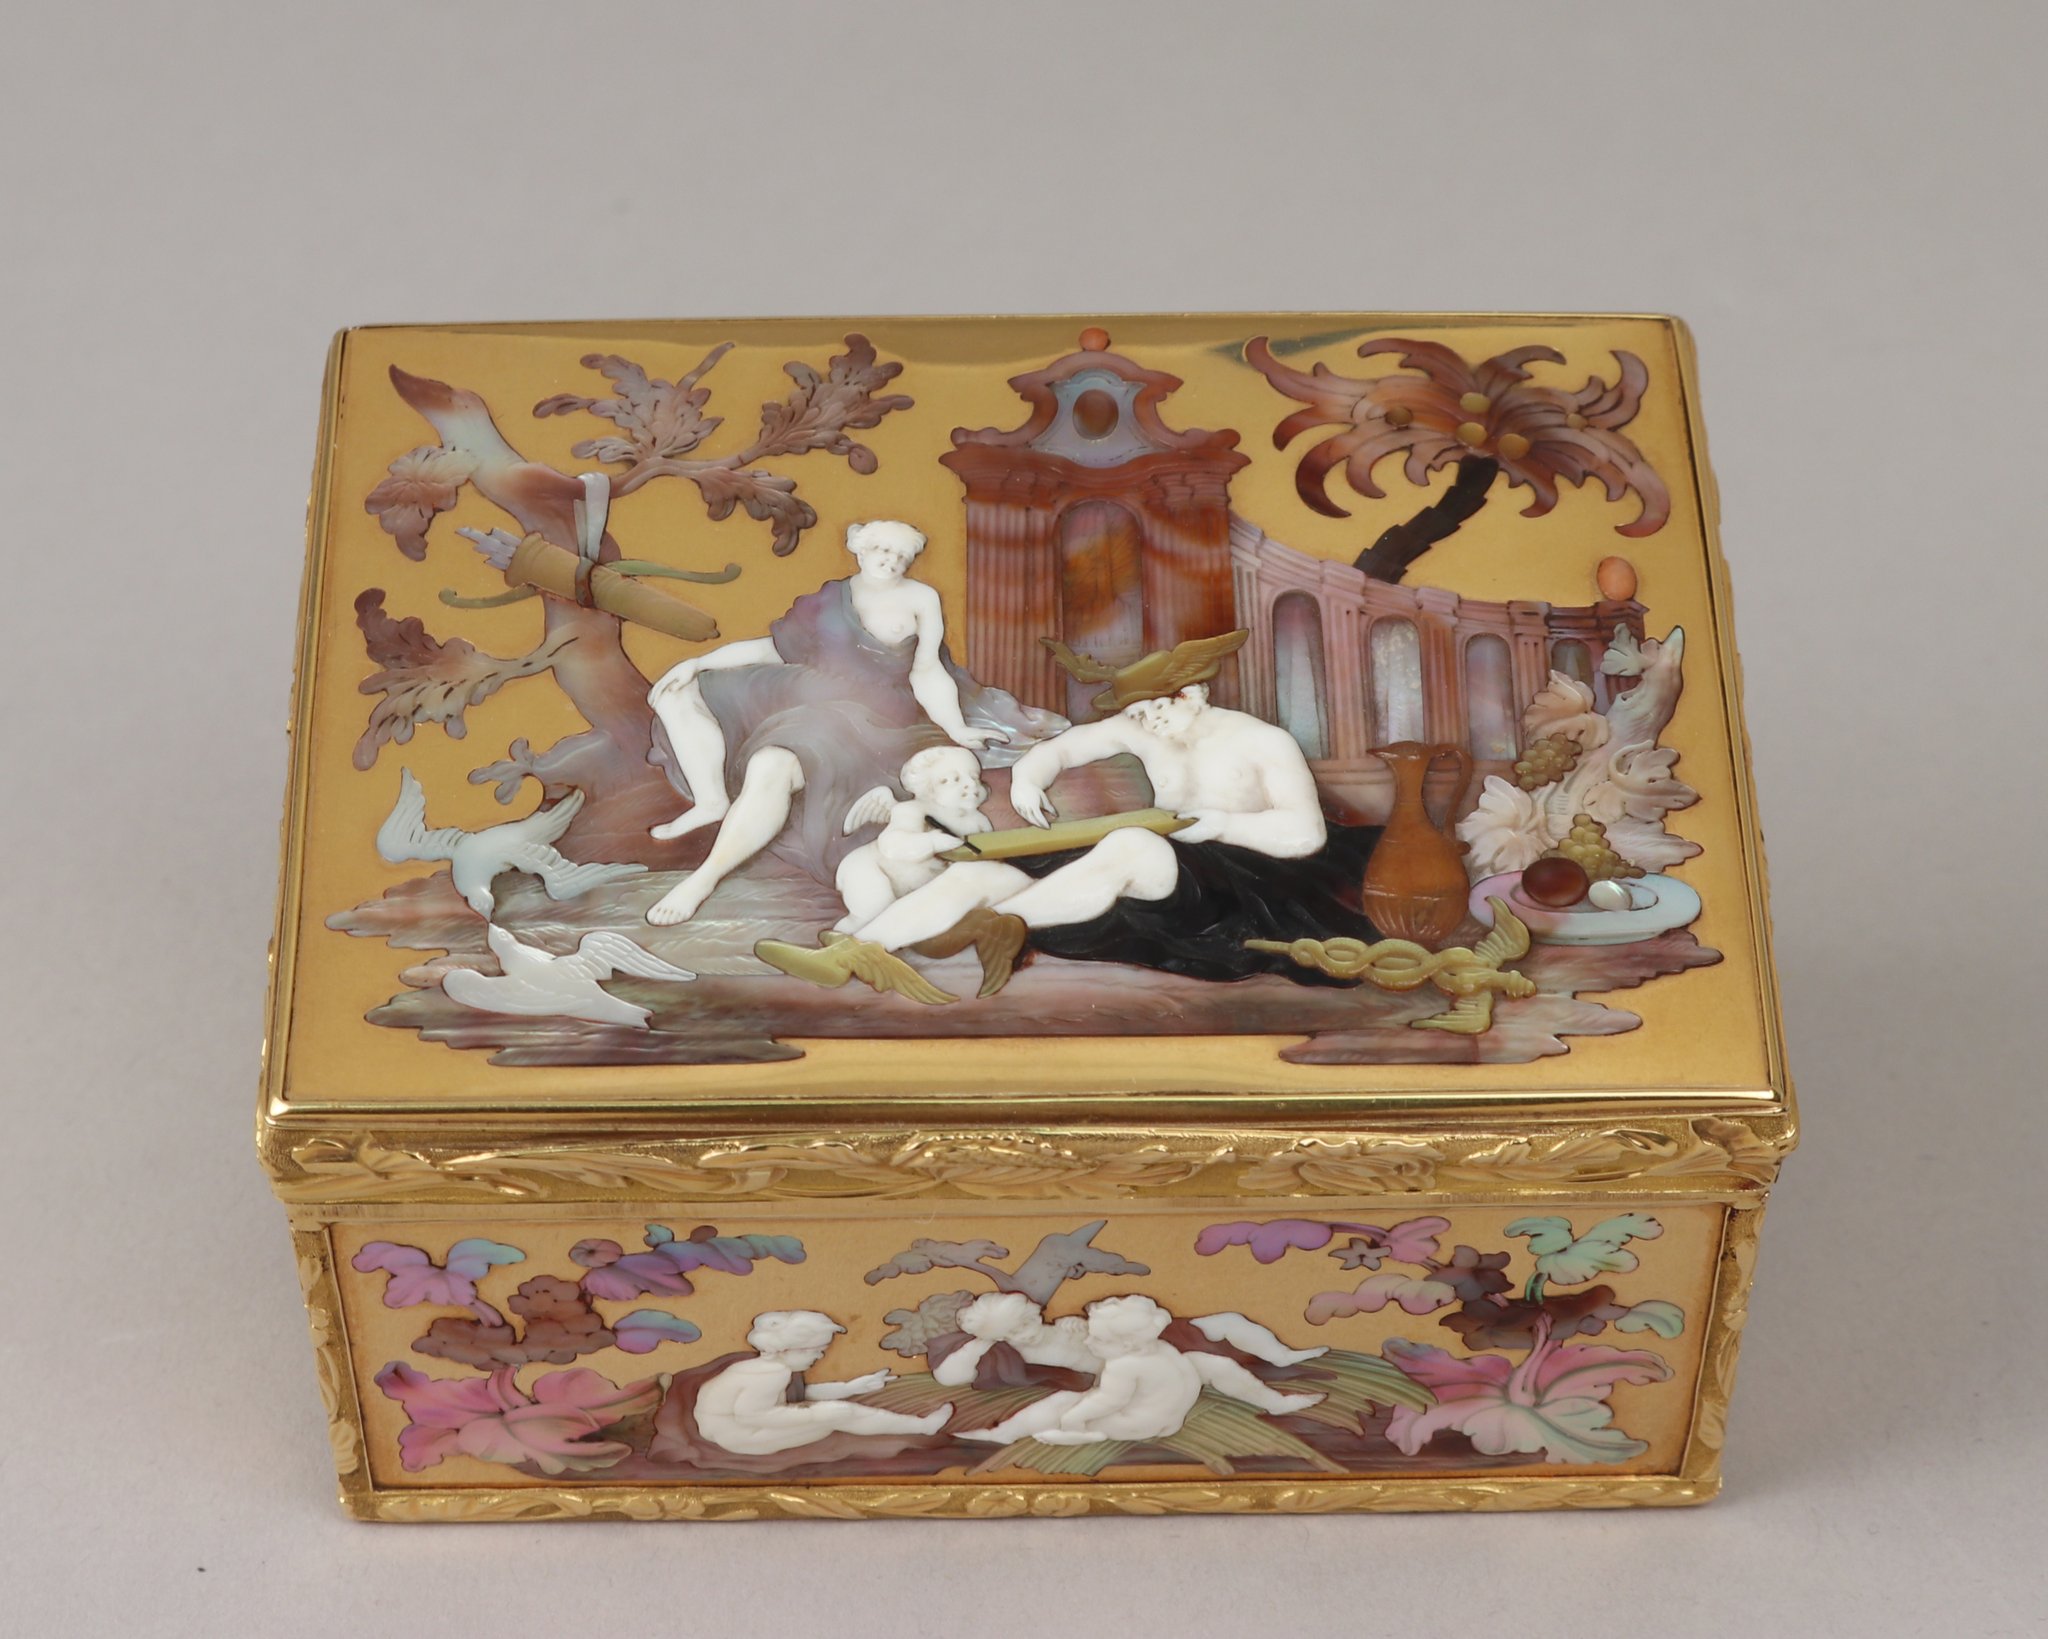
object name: snuffbox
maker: michel de lassus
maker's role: maker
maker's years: 1672-1772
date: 1749-1750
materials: gold, ivory, mother of pearl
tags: children,women,flowers